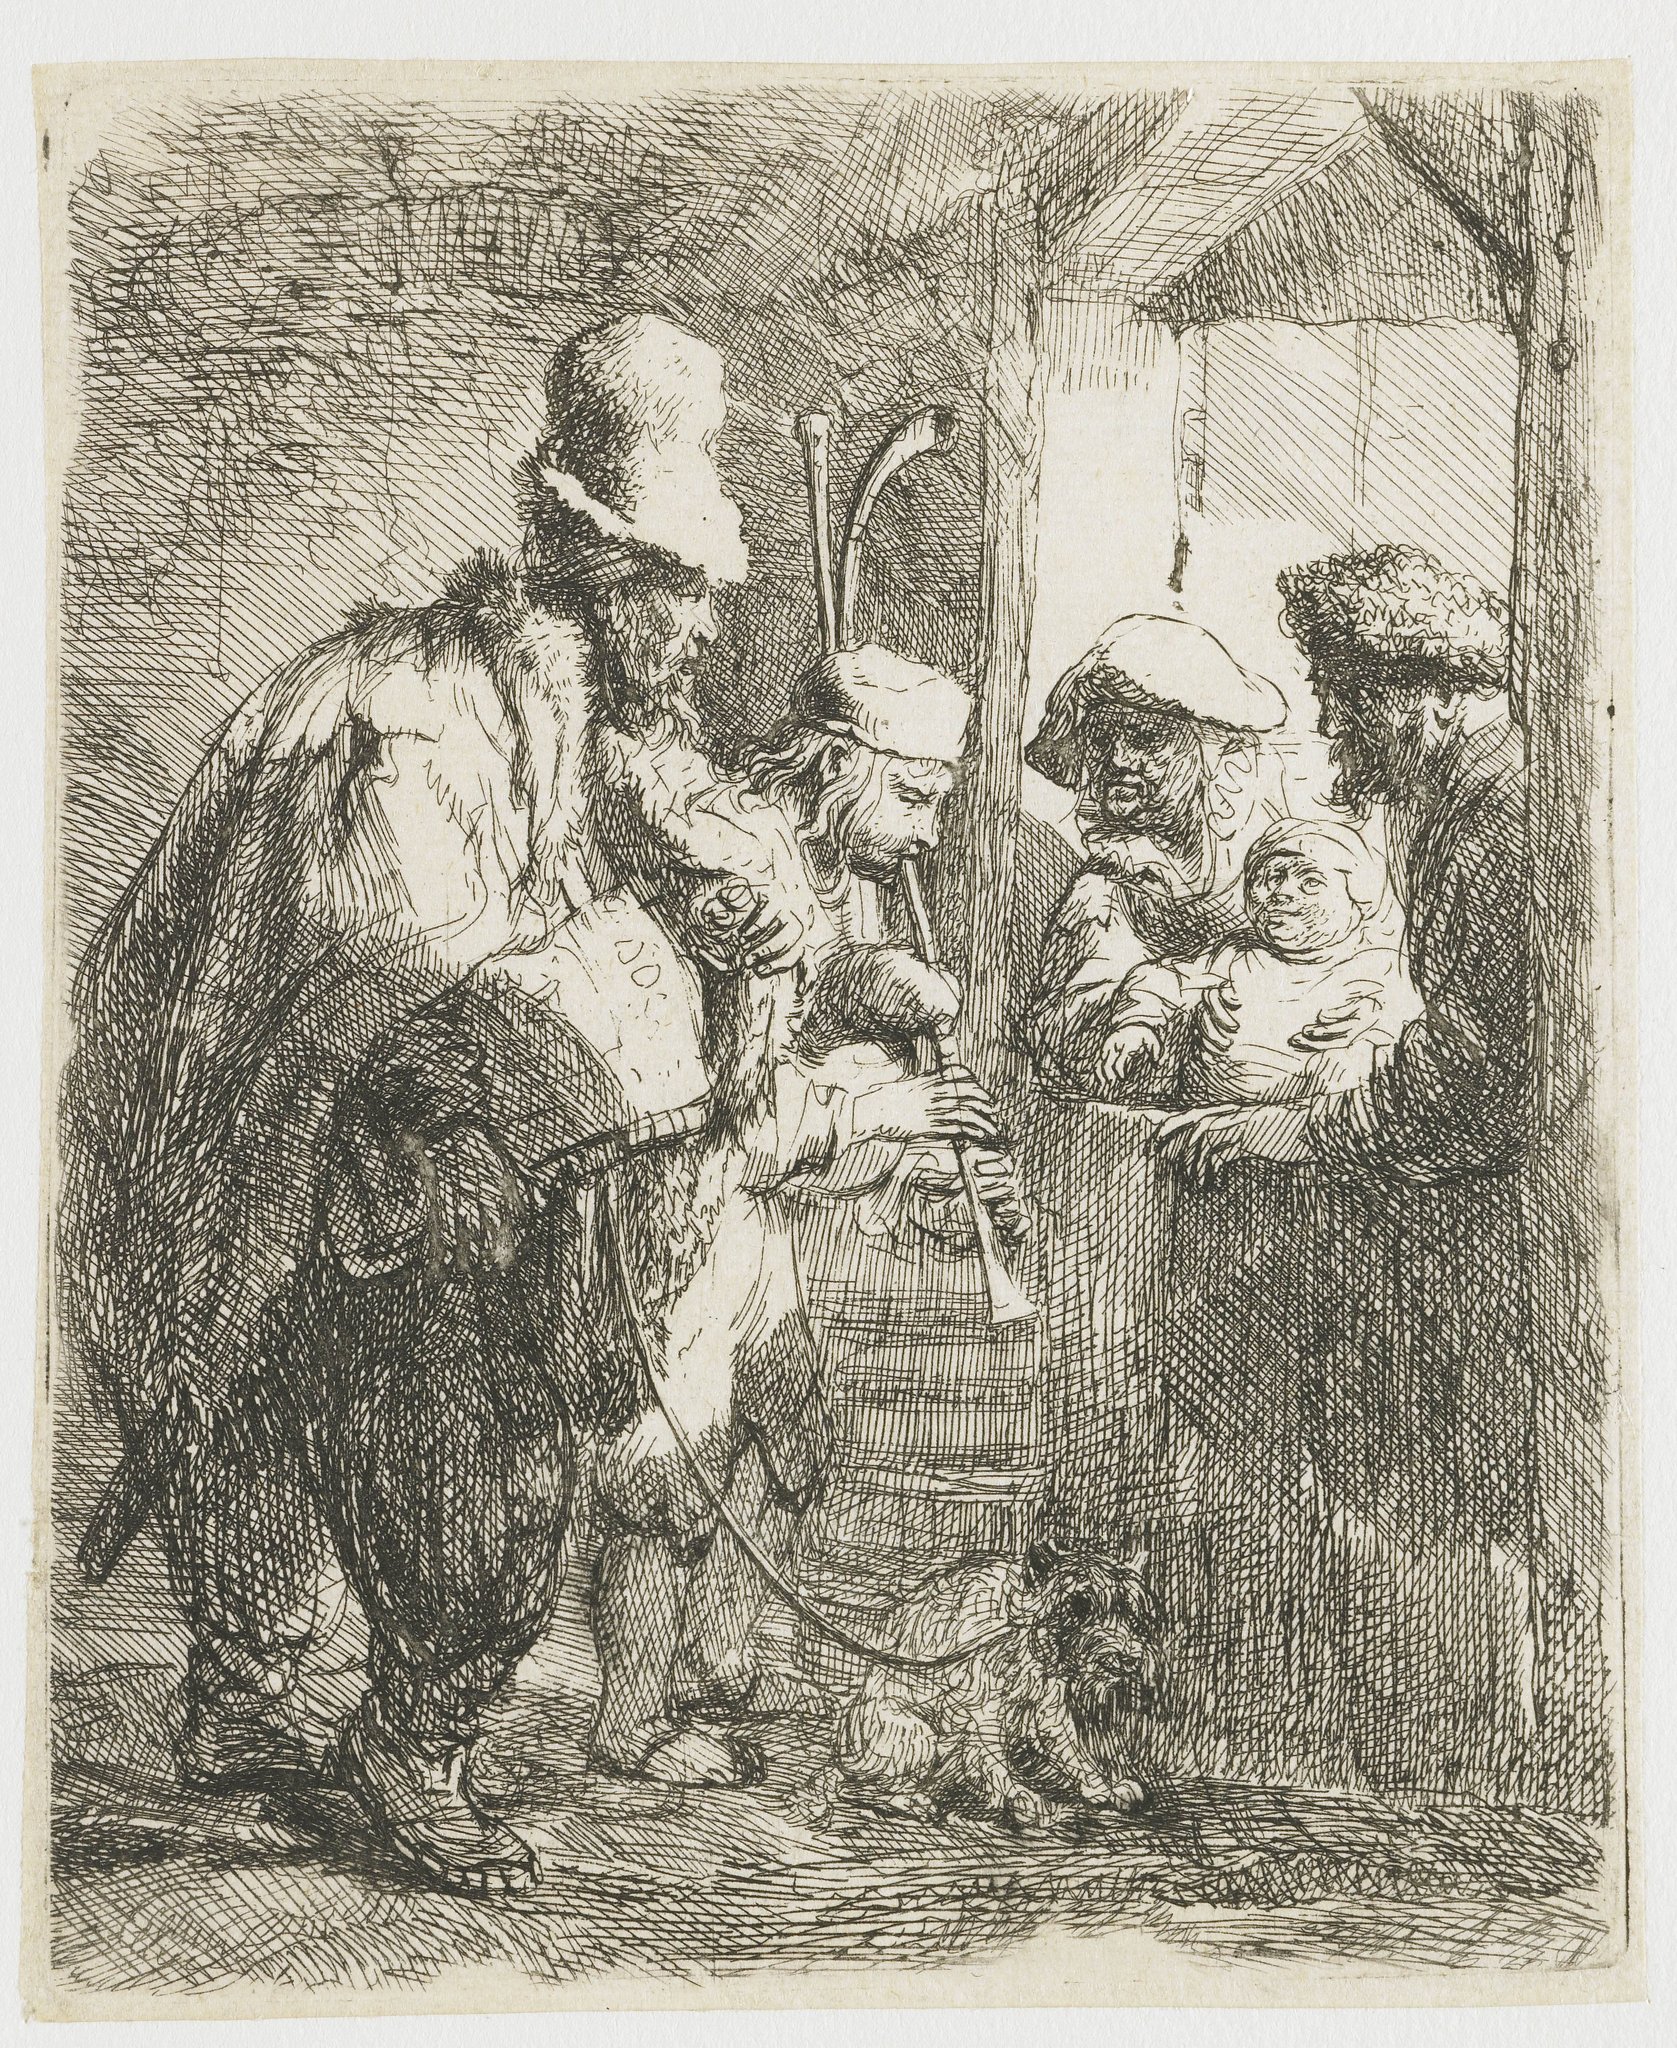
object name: print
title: The strolling musicians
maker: rembrandt van rijn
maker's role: draughtsman, painter, print maker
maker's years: 1606-1669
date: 1635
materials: paper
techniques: etching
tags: more than one musician with instrument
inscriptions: mark: Lugt 2228